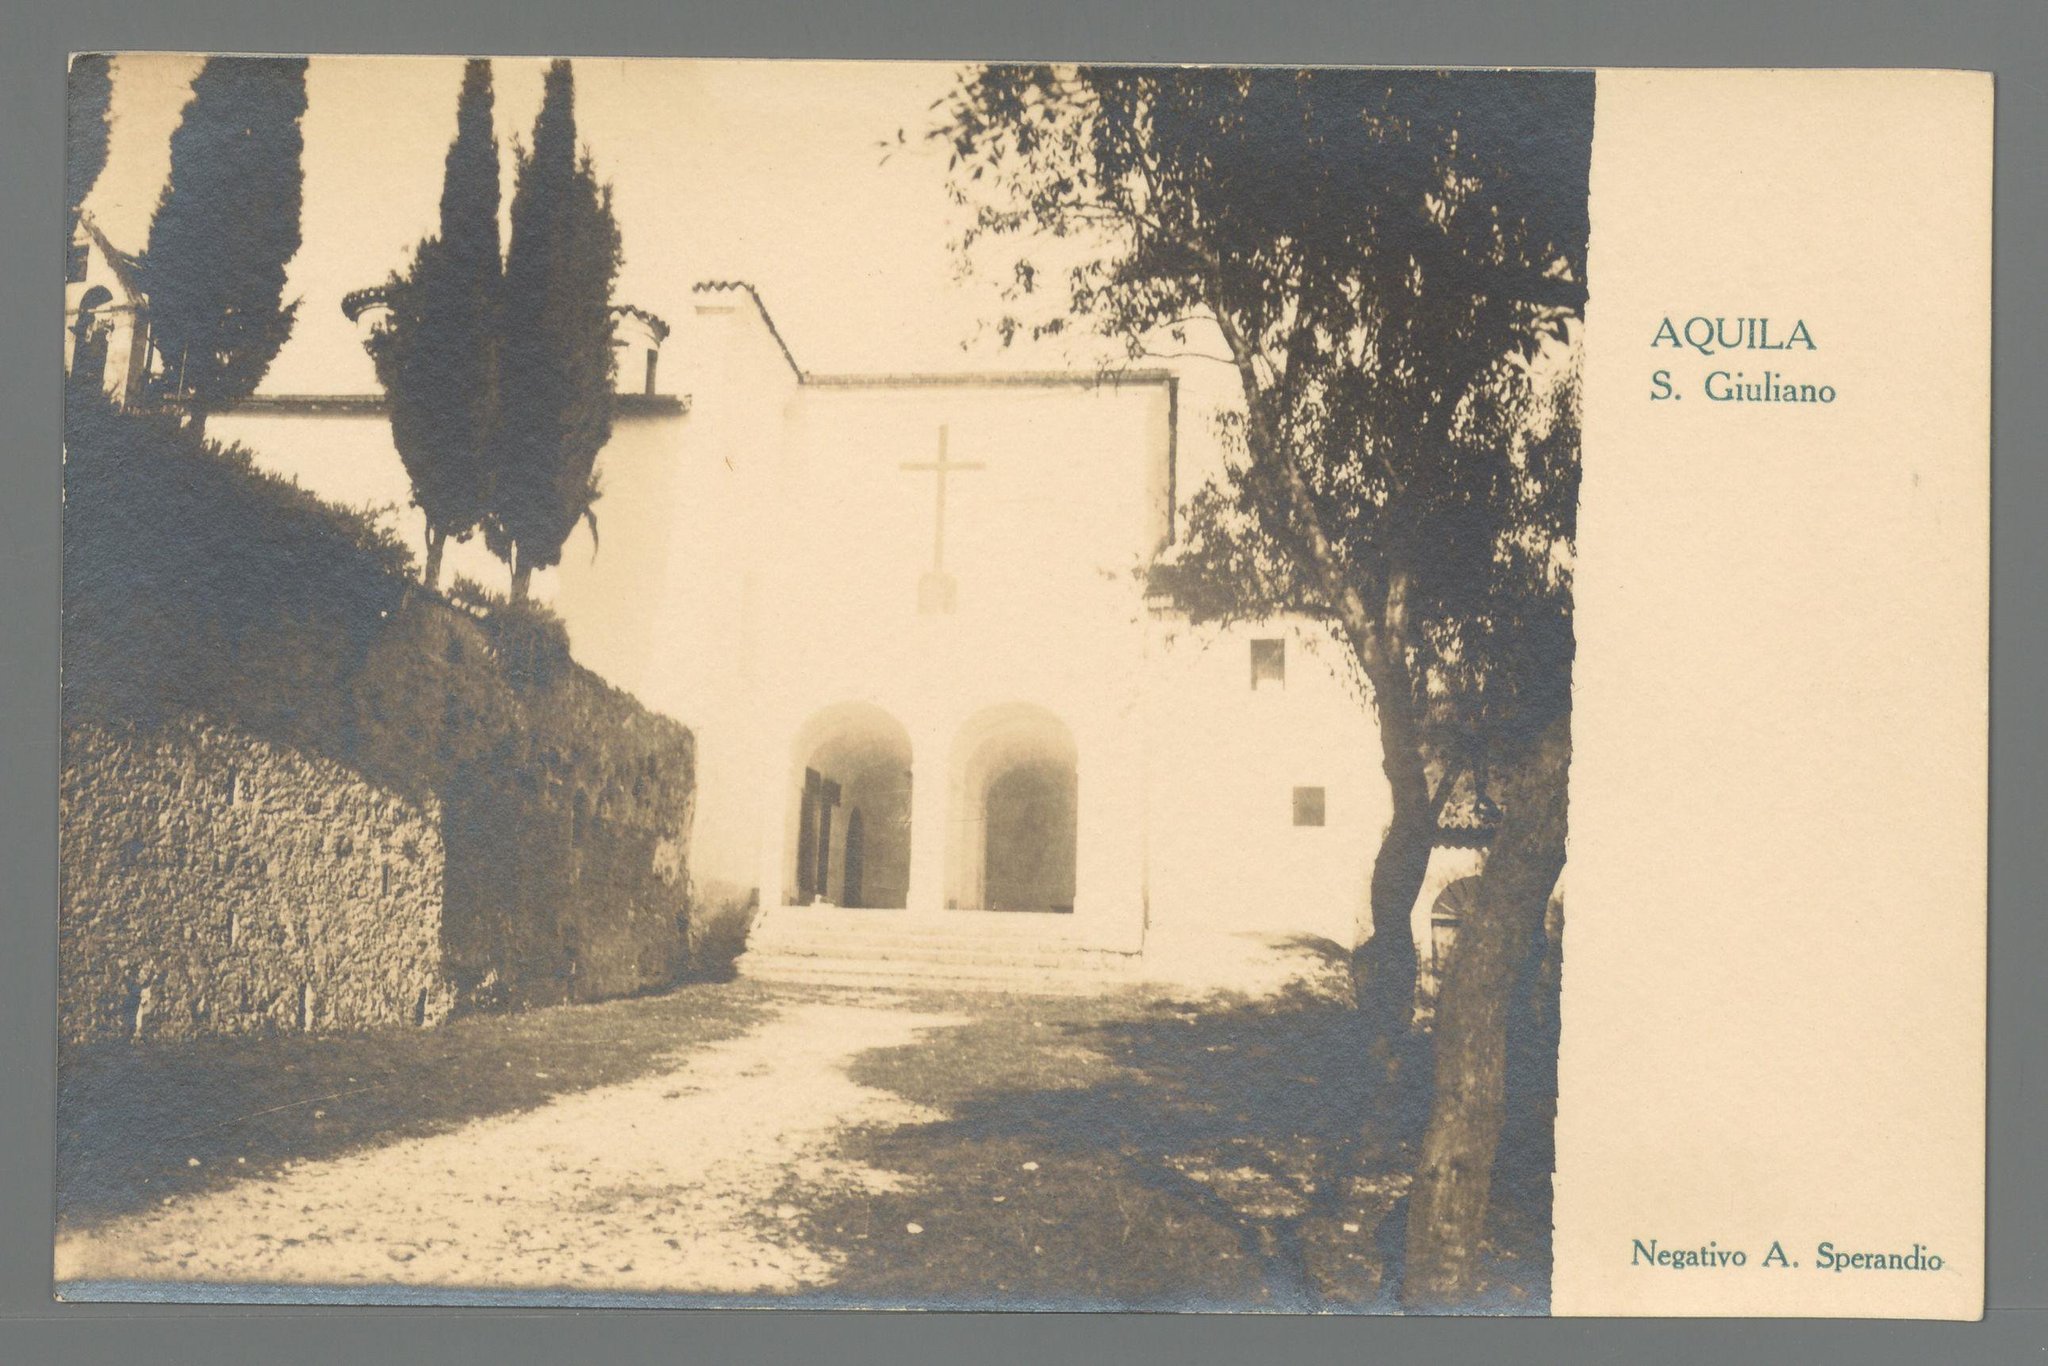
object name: photograph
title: Aquila. S. Giuliano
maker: a. sperandio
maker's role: fotograaf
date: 1912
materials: paper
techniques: gelatin silver print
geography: l'aquila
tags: square, place, circus, etc., church (exterior)